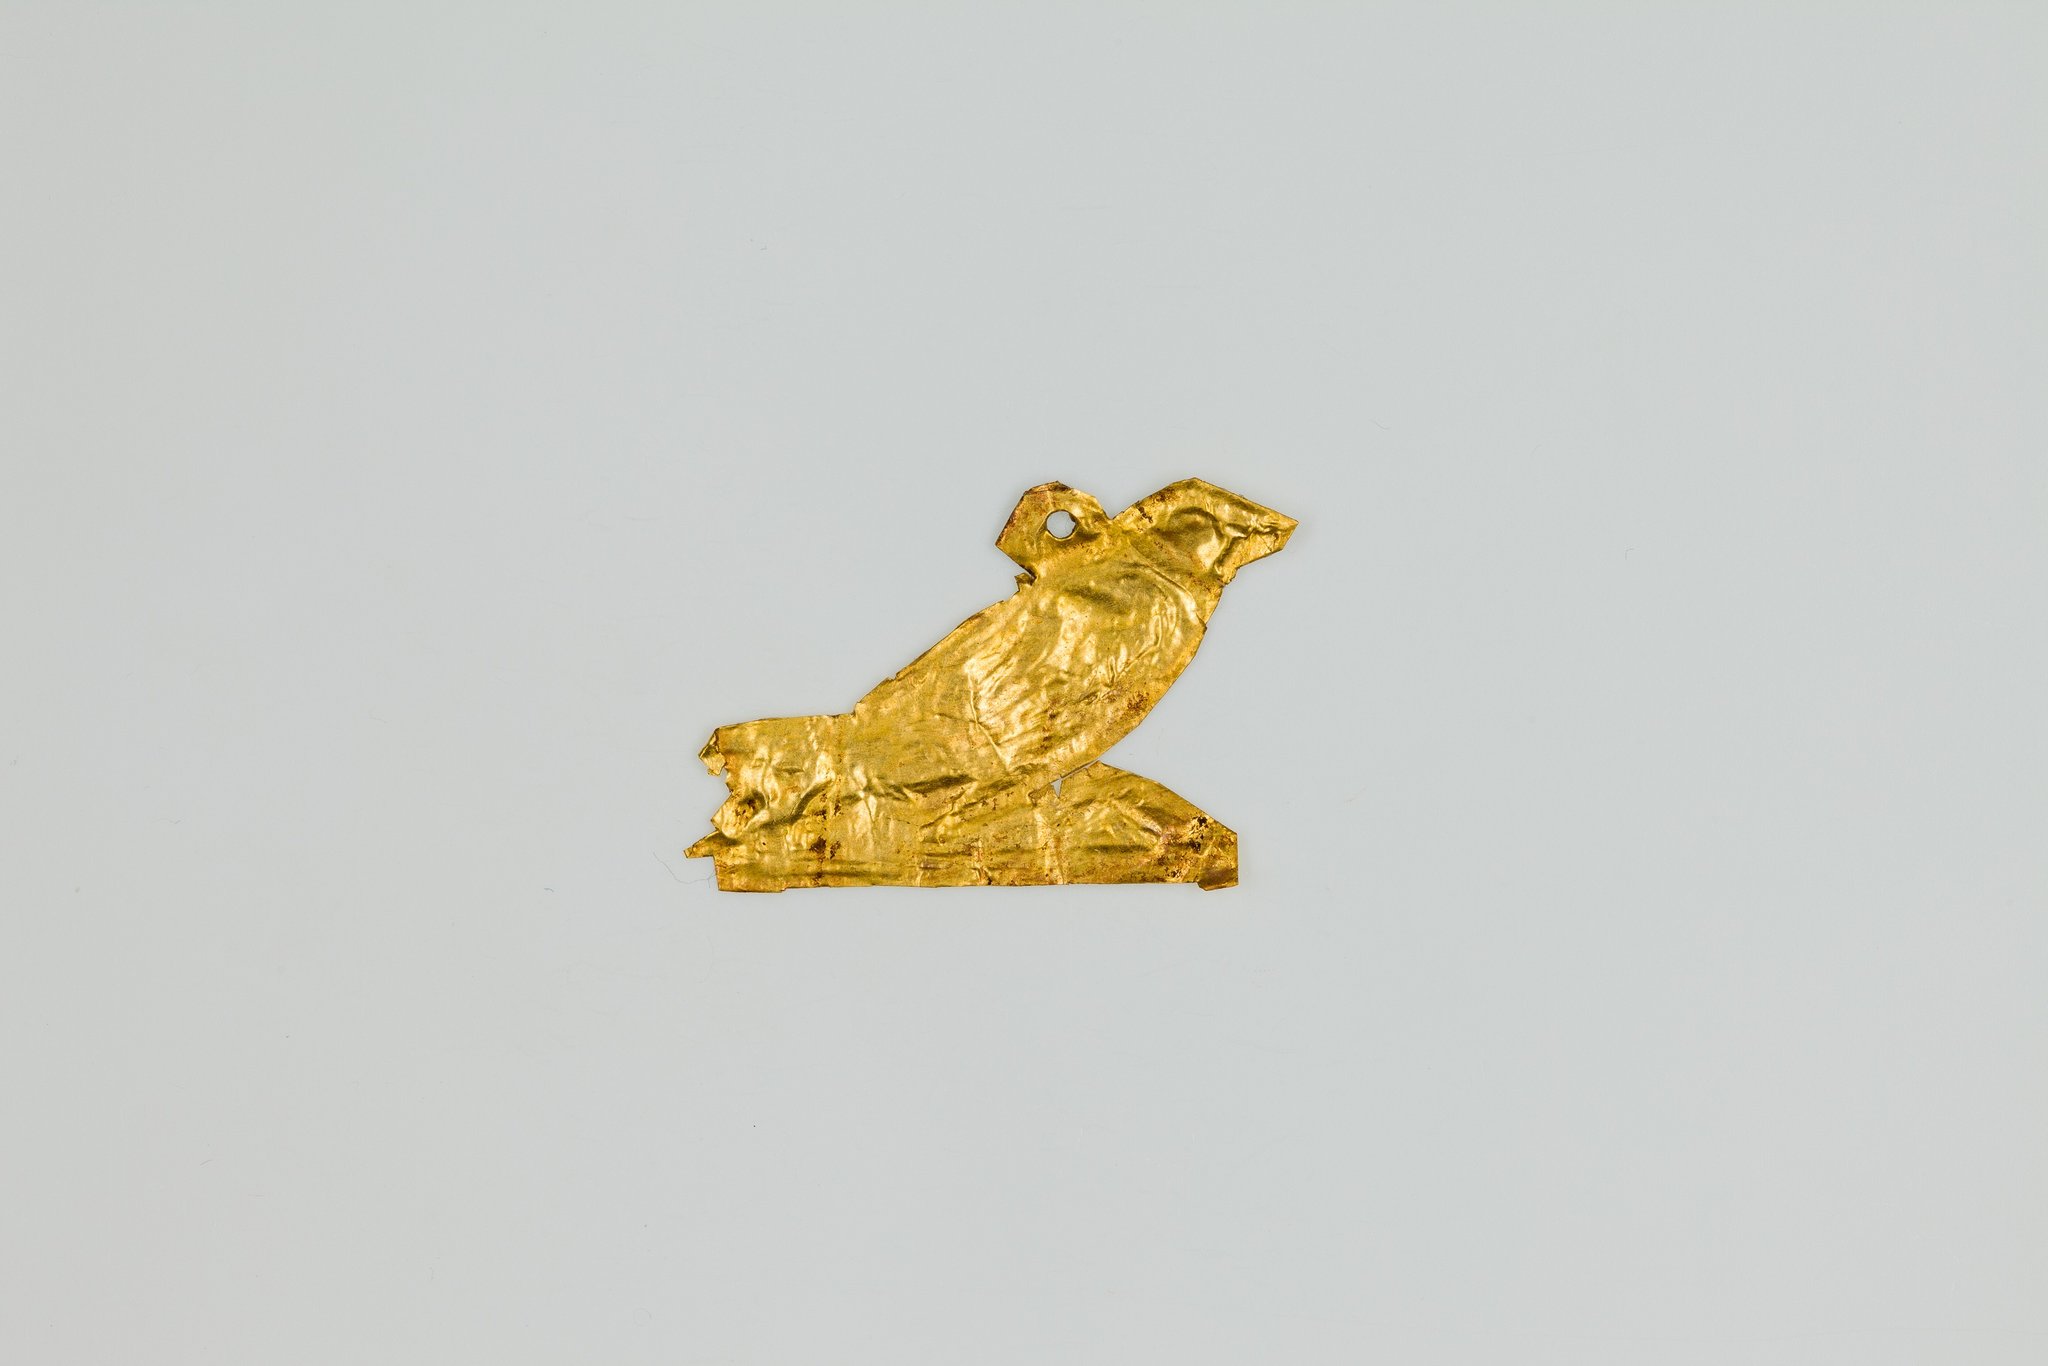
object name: amulet, swallow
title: Swallow amulet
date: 664-380 BCE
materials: gold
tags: birds